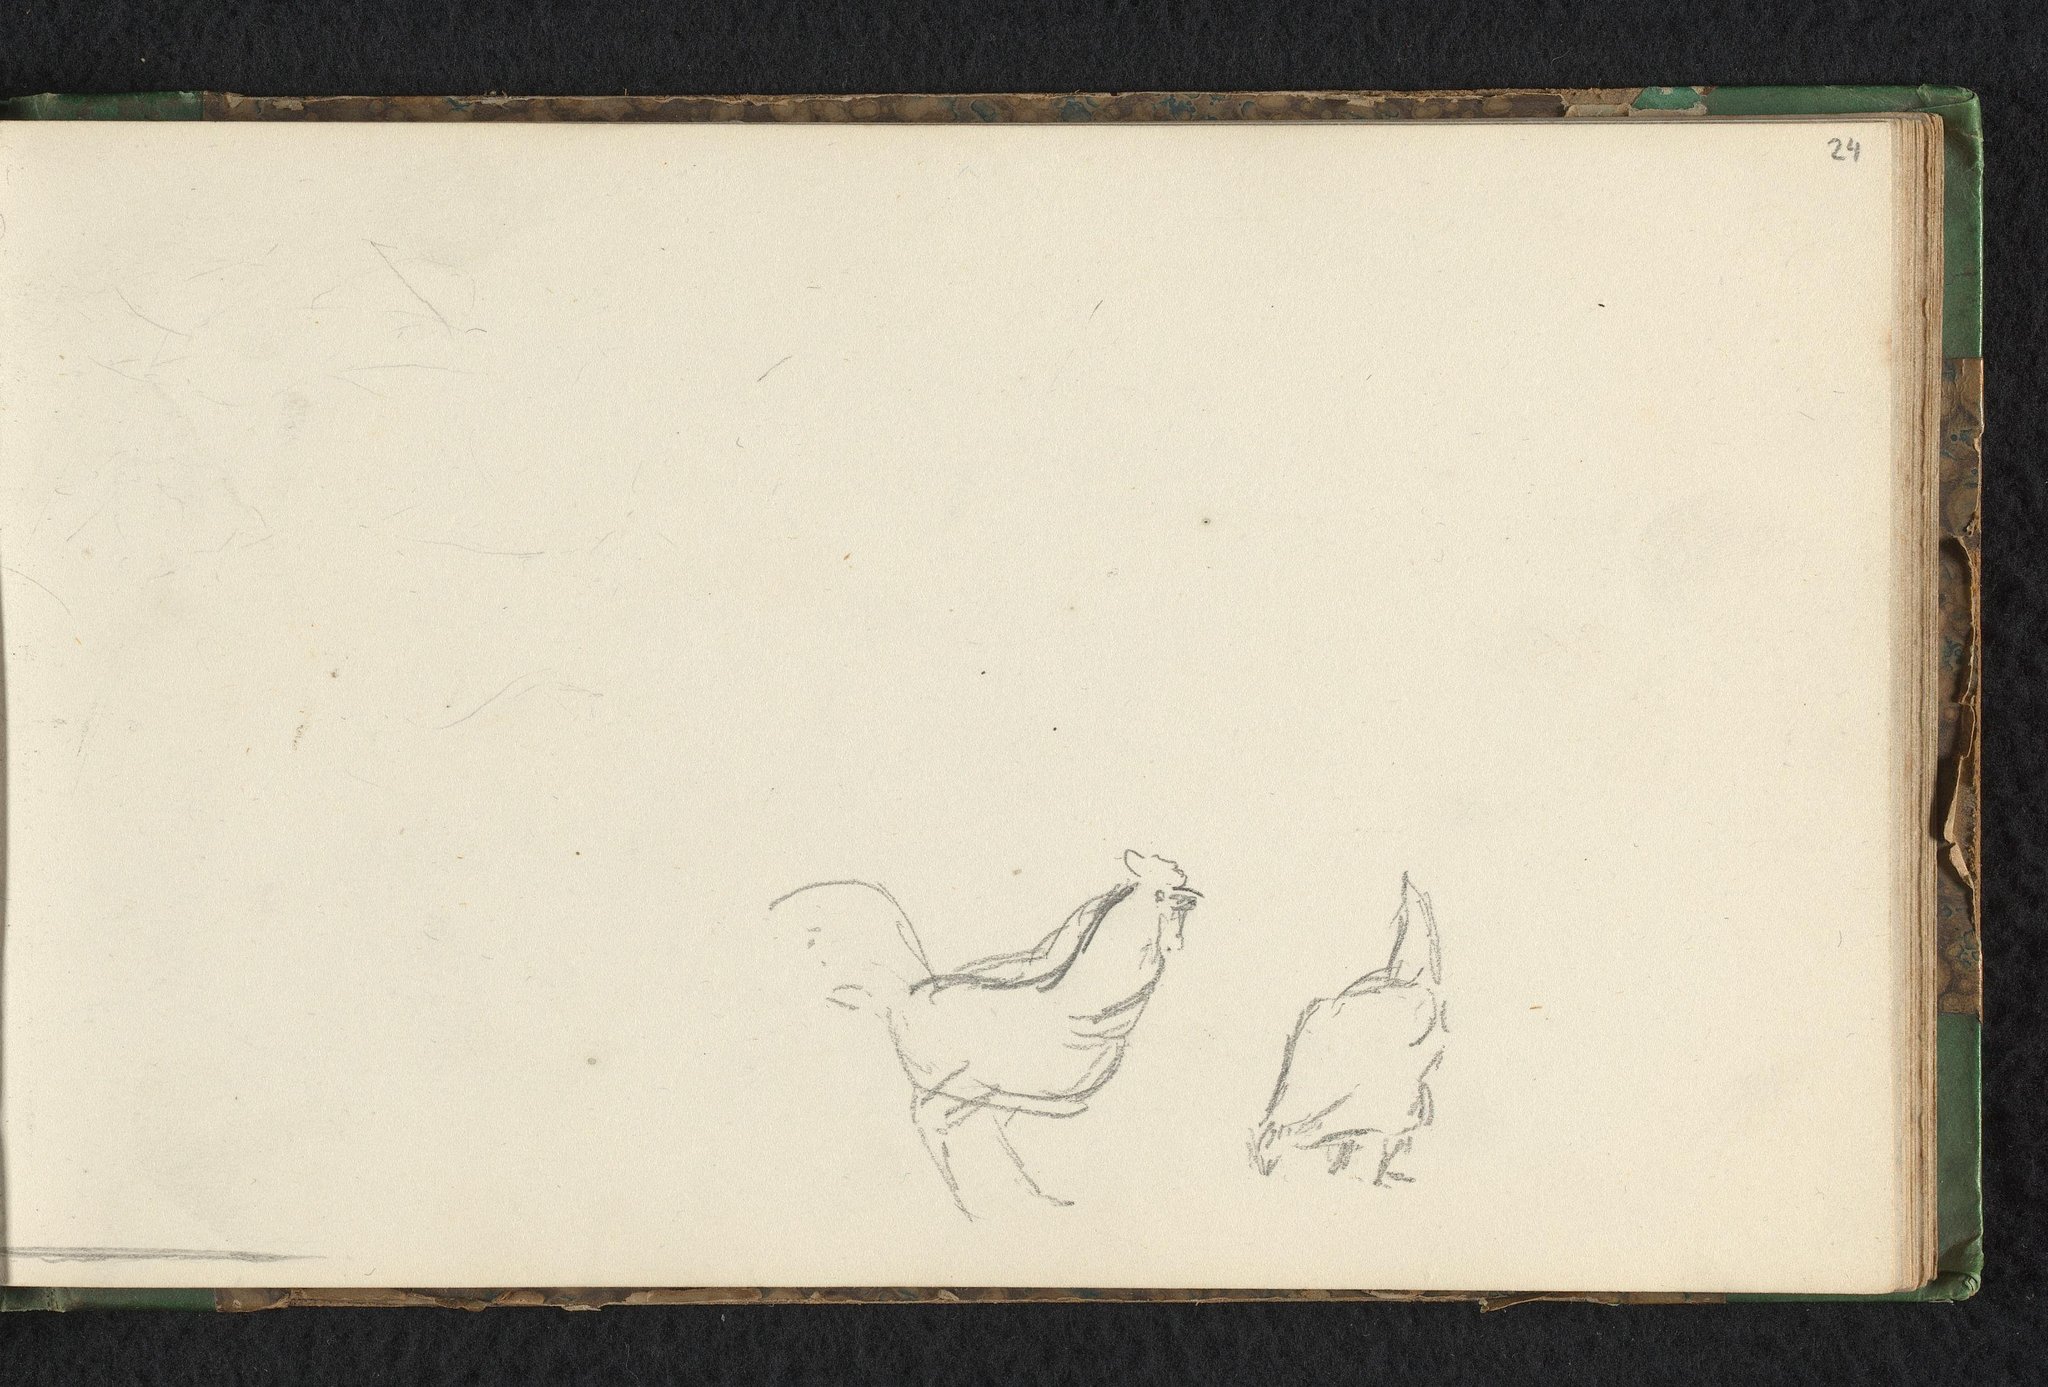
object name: sketchbook leaf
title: Twee kippen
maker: jan bedijs tom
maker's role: draughtsman, painter, print maker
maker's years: 1813-1894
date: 1823-1894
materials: paper, pencil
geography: the hague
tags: fowl (cock, hen, chicken, etc.)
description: Pagina 24 recto uit een schetsboek met 61 bladen.